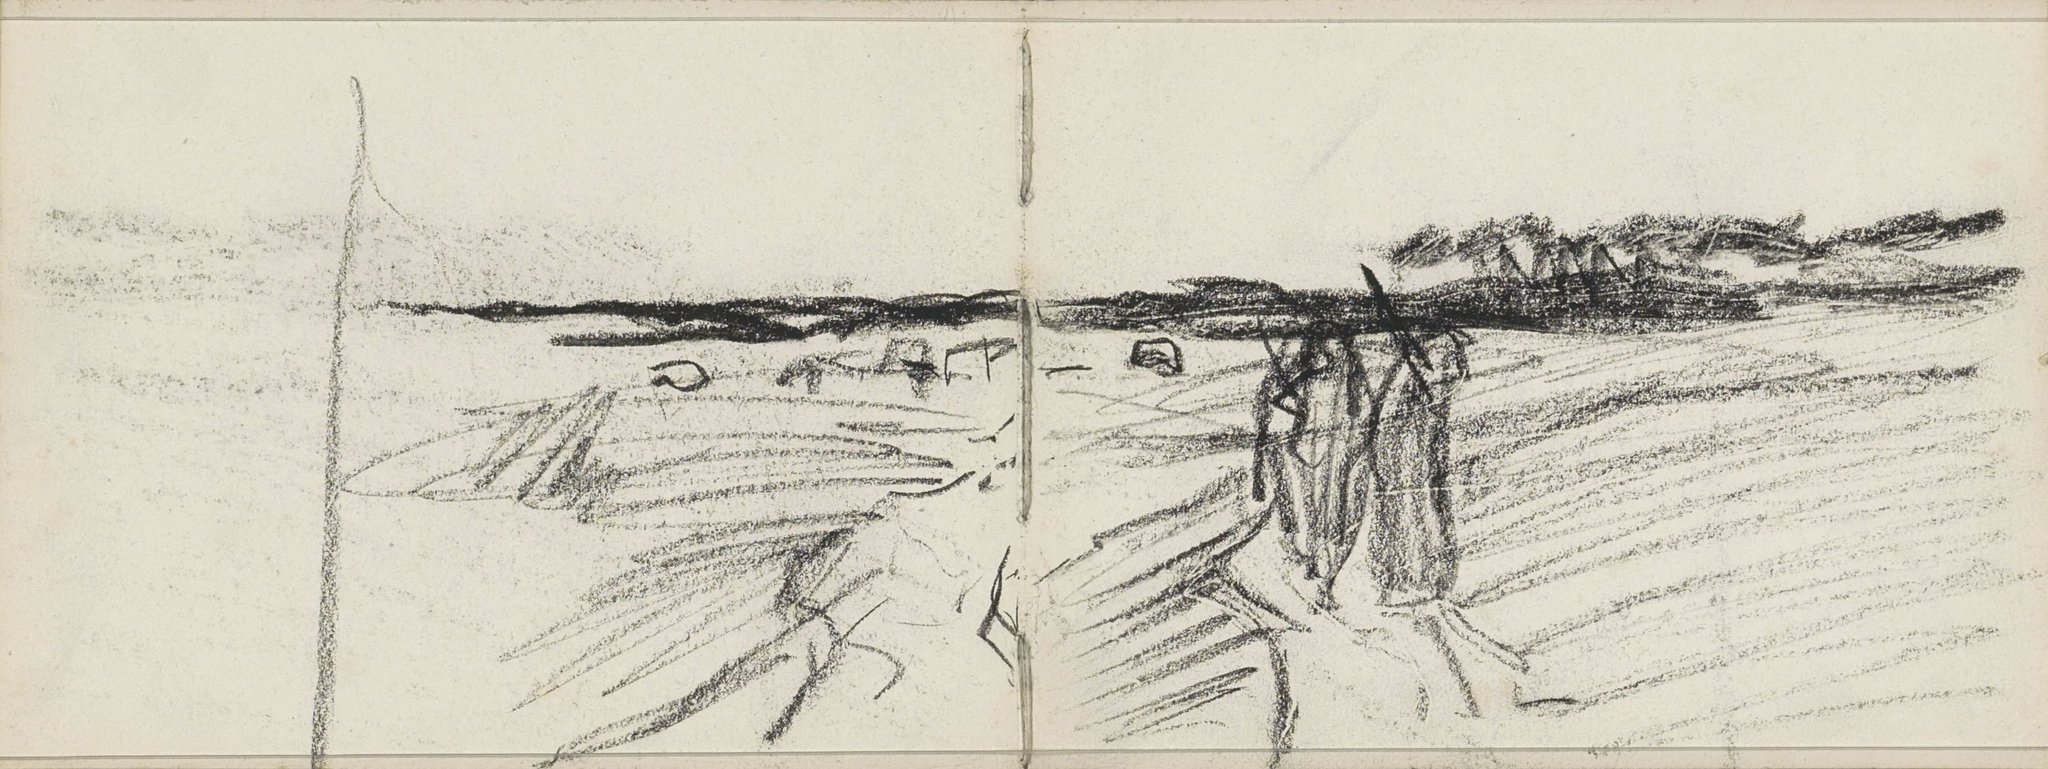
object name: sketchbook leaf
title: Arbeiders op het land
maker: anton mauve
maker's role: draughtsman, painter, print maker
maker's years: 1838-1888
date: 1881-1888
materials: chalk, paper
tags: agriculture, landscapes (+ landscape with figures, staffage)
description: Blad 8 verso en 9 recto uit een schetsboek met 29 bladen.